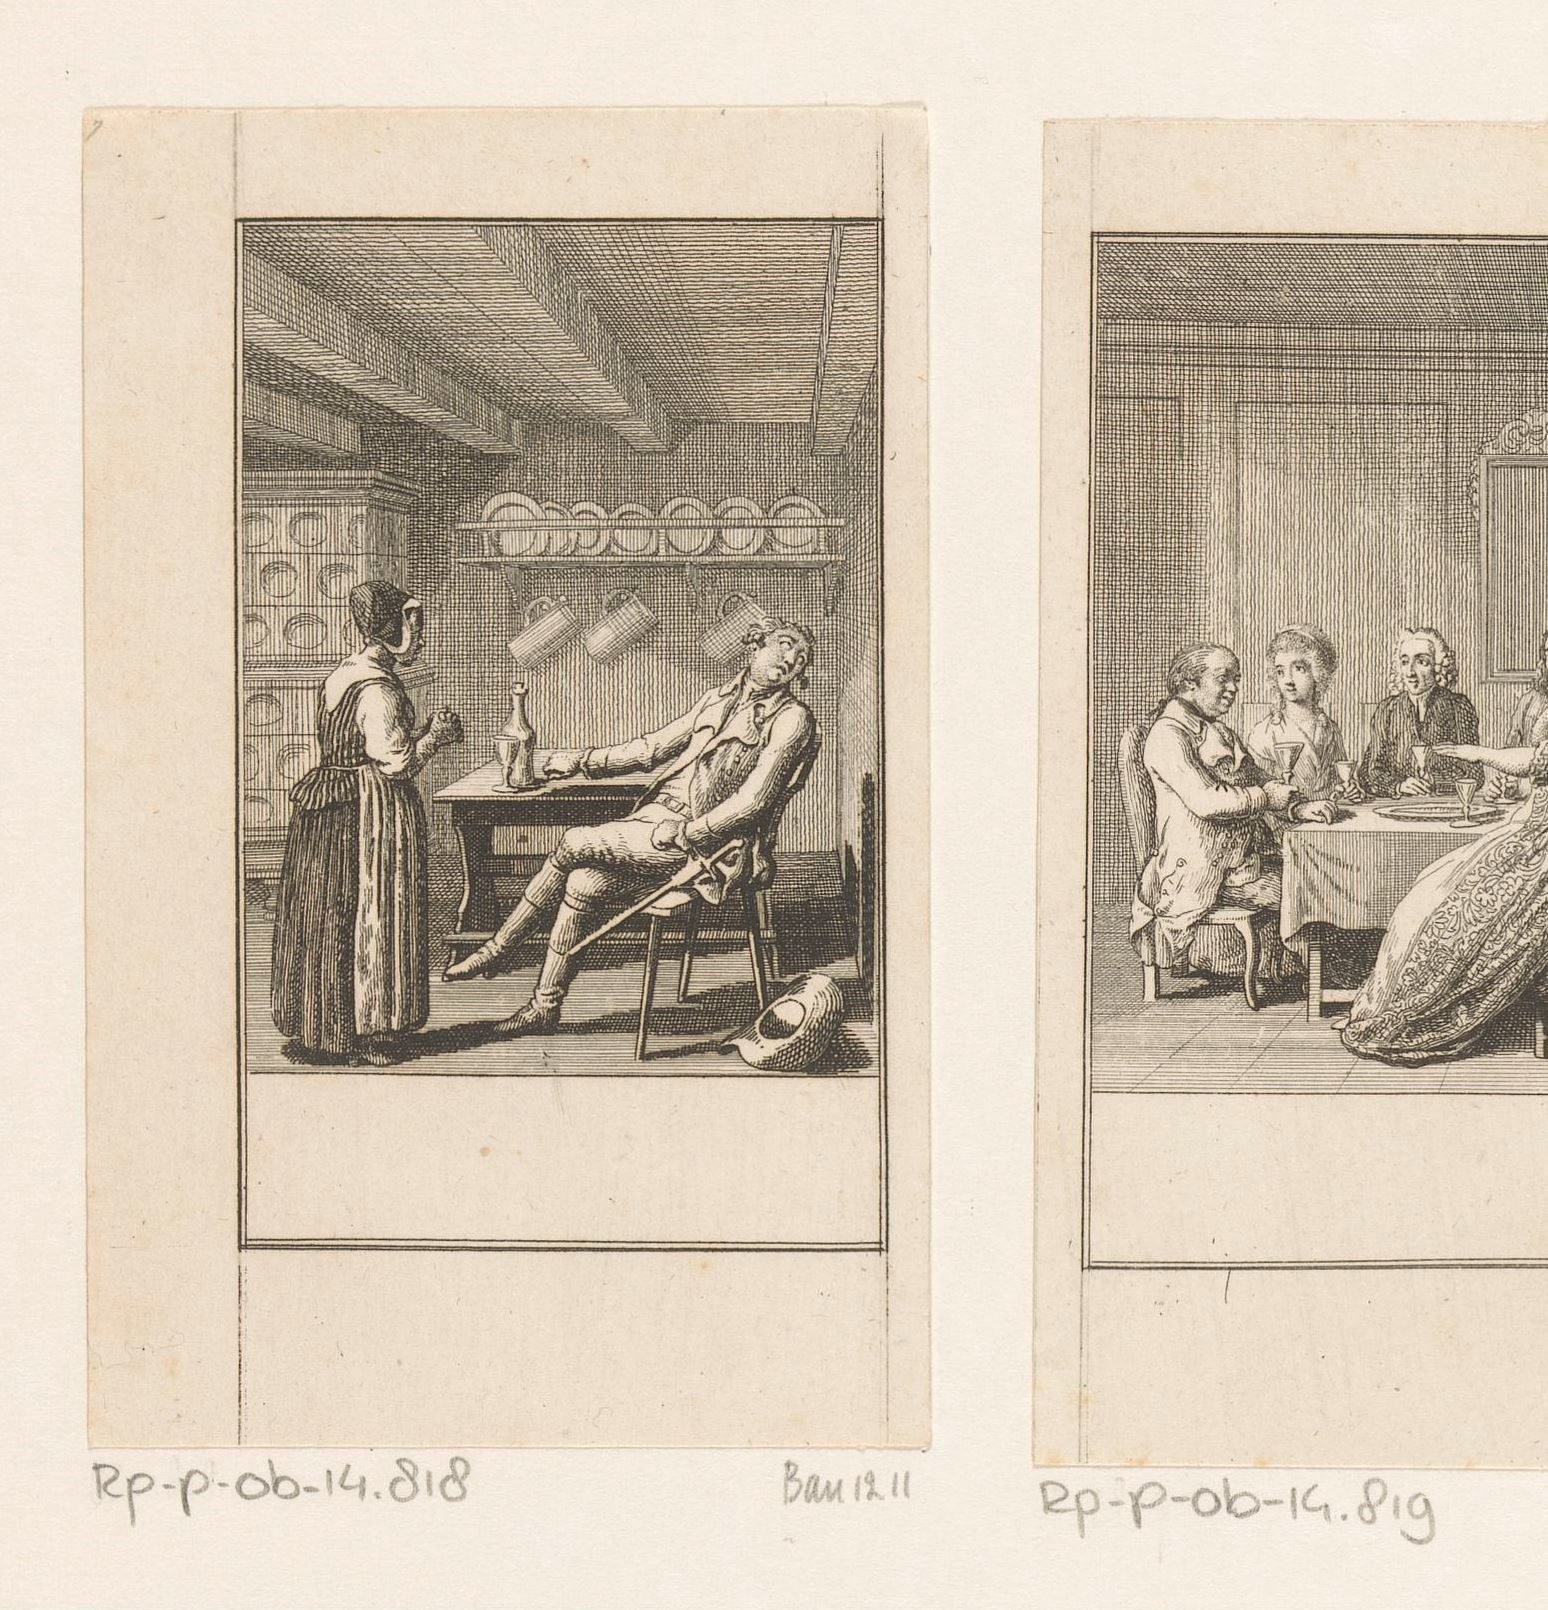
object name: print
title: Anton in de herberg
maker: daniel nikolaus chodowiecki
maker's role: draughtsman, print maker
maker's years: 1726-1801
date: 1786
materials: paper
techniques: etching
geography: berlin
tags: literature, drinking, hotel, hostelry, inn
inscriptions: collector's mark: Lugt 2228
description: Vervaardigd voor August Wilhelm Ifflands 'Die Jäger'. Latere staat gebruikt voor: Berliner genealogischen Calender auf das Jahr 1787. Berlijn: s.n., 1786.